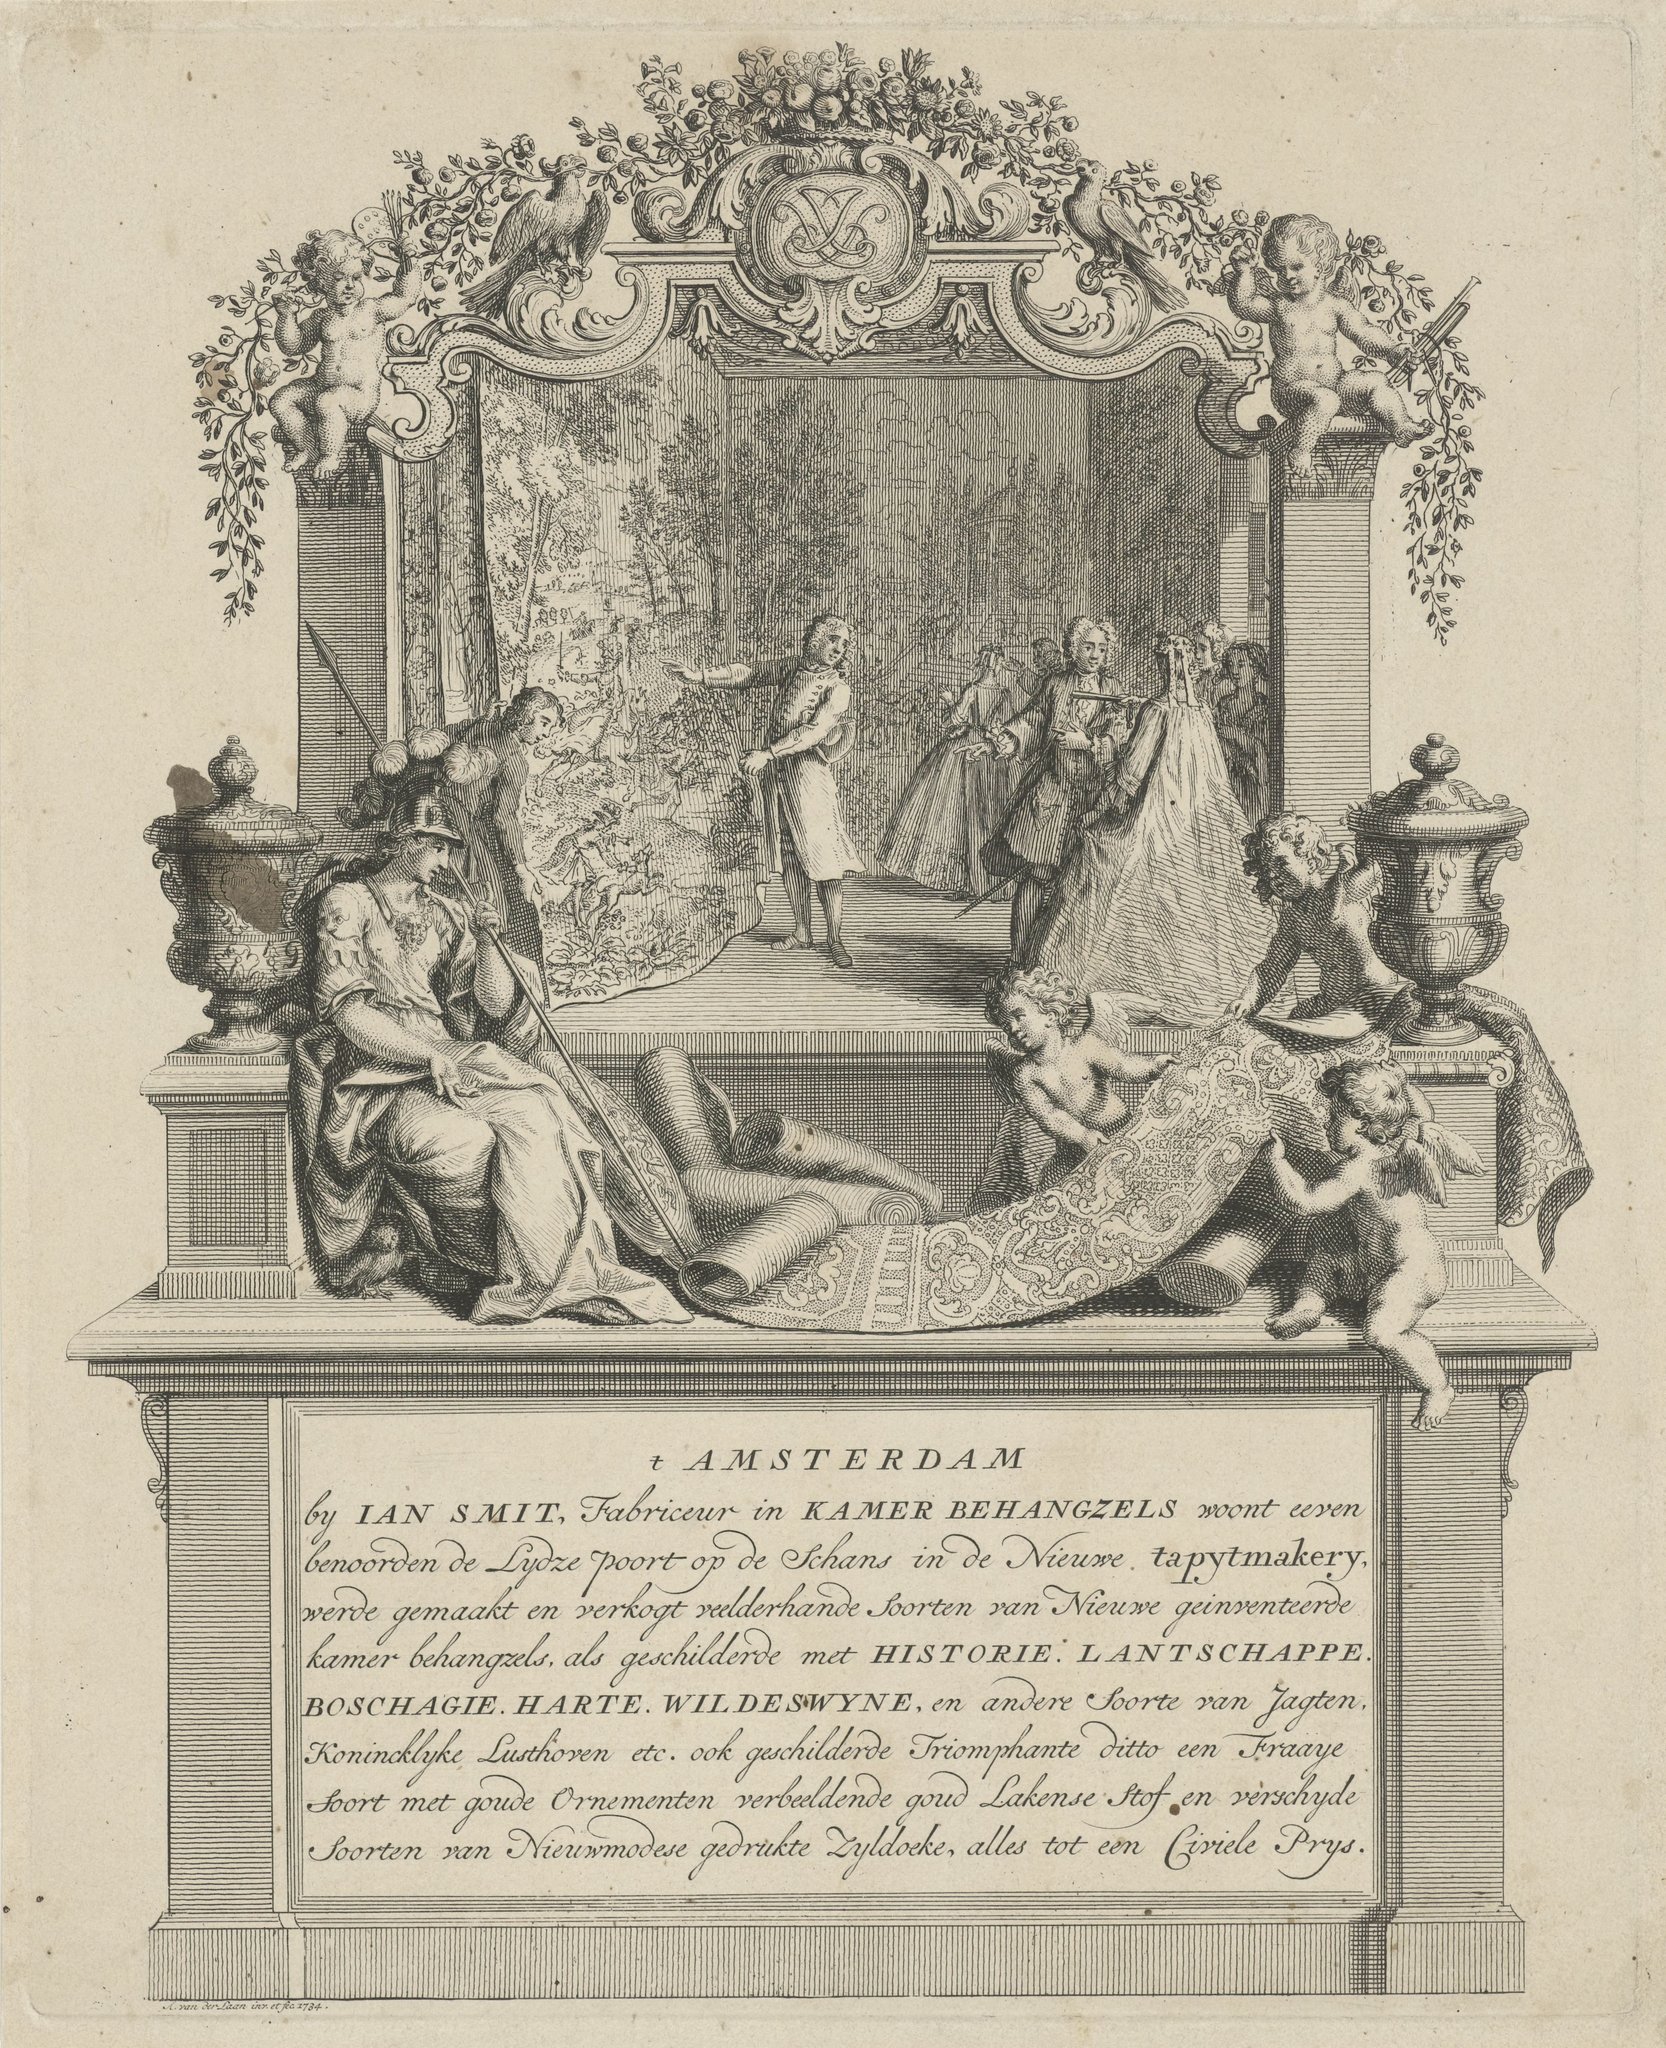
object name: business card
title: Adreskaart van Jan Smit, fabrikant van kamerbehangsels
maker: adolf van der laan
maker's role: draughtsman, print maker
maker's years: 1689-1742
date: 1734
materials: paper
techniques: etching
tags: wall-paper, (story of) minerva (pallas, athena), cupids: 'amores', 'amoretti', 'putti'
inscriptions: collector's mark: Lugt 2228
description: Adreskaart van Jan Smit, fabrikant van kamerbehangsels. Op de voorgrond aanschouwt Minerva het behang dat door drie putti voor haar voeten is uitgerold. Hierachter toont de fabrikant een behangsel aan een aantal klanten. Het geheel is gevat in een architecturale omlijsting die van boven versierd is met putti, bloemen, vruchten, pagegaaien en een monogram. Onder een opschrift van negen regels.